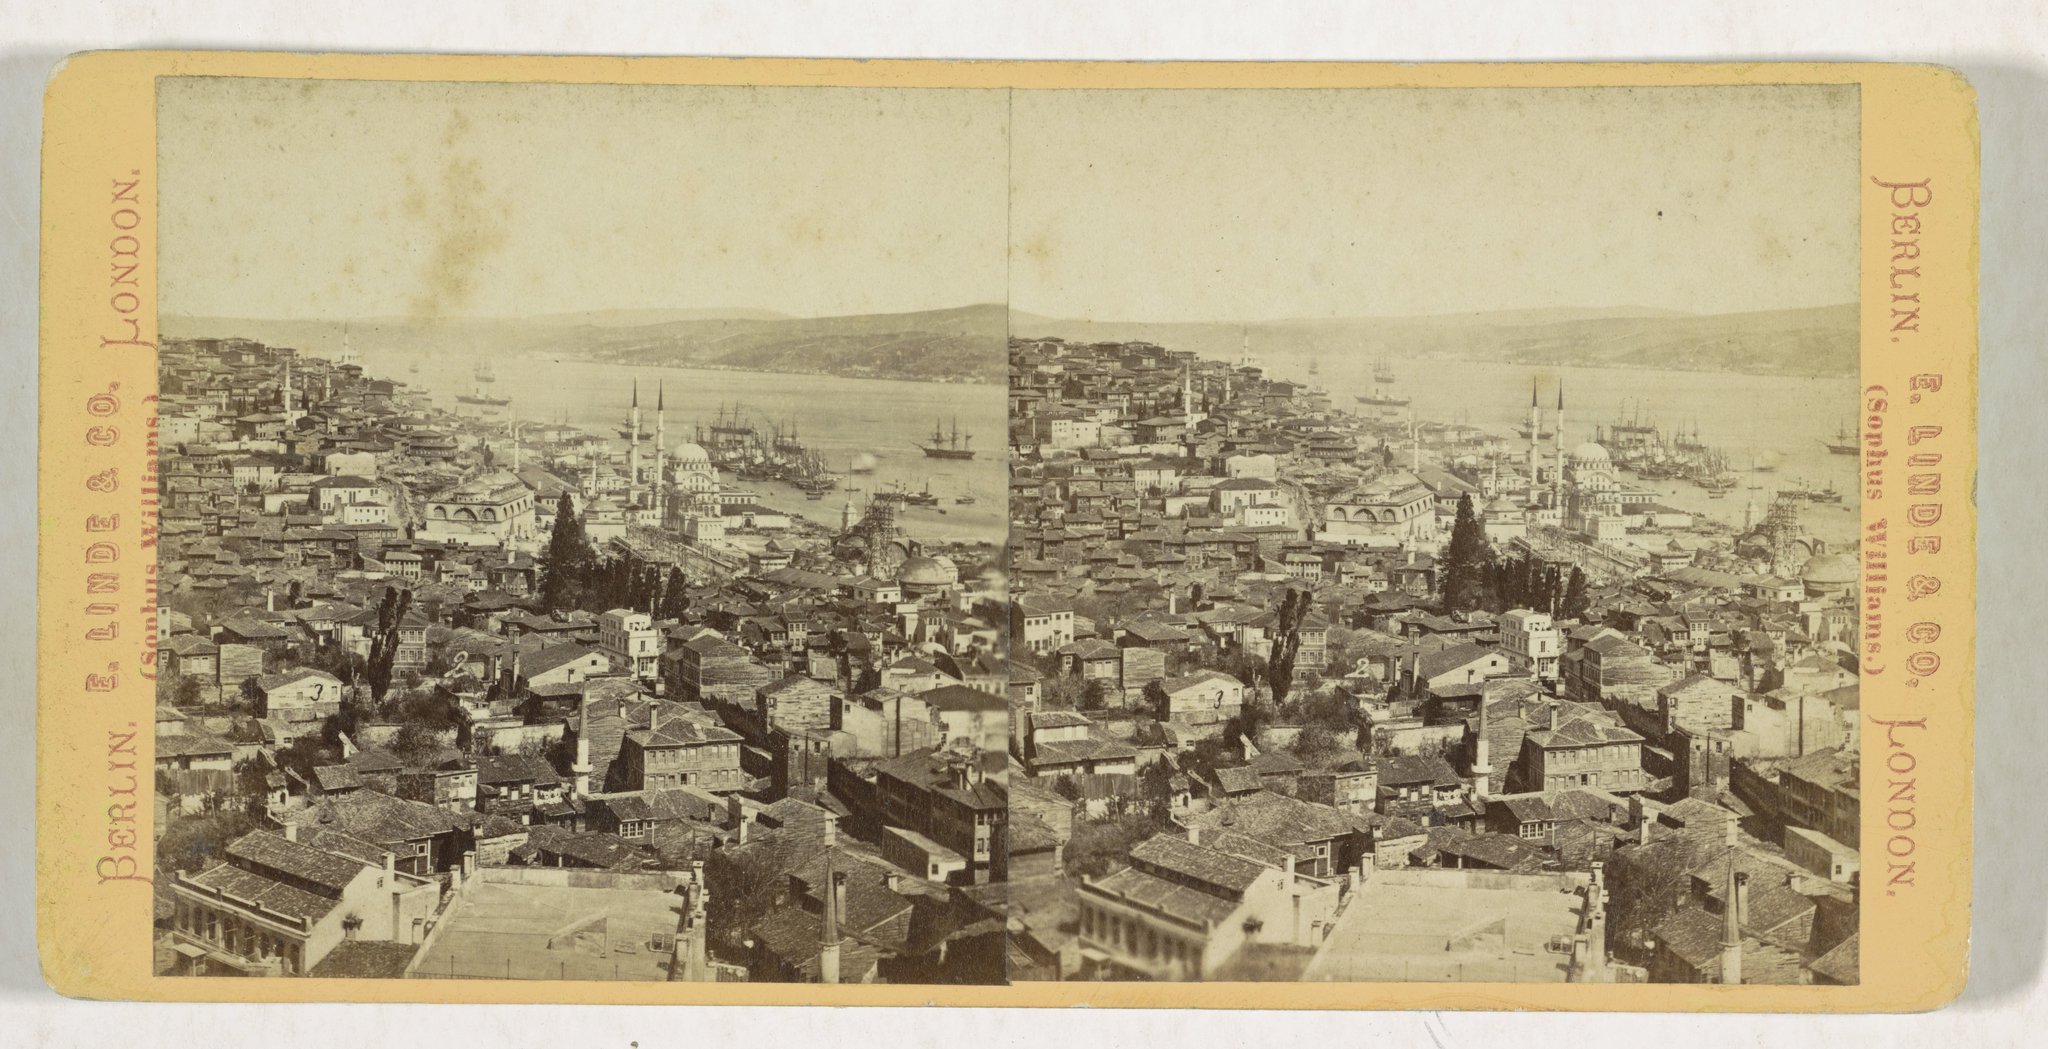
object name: stereograph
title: Gezicht op Findikli, Beyoğlu vanaf Tophane, Istanboel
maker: Anonymous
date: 1873-1890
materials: cardboard, paper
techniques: albumen print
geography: findikli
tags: city-view in general; 'veduta'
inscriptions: number: ‘3’, number: ‘2’